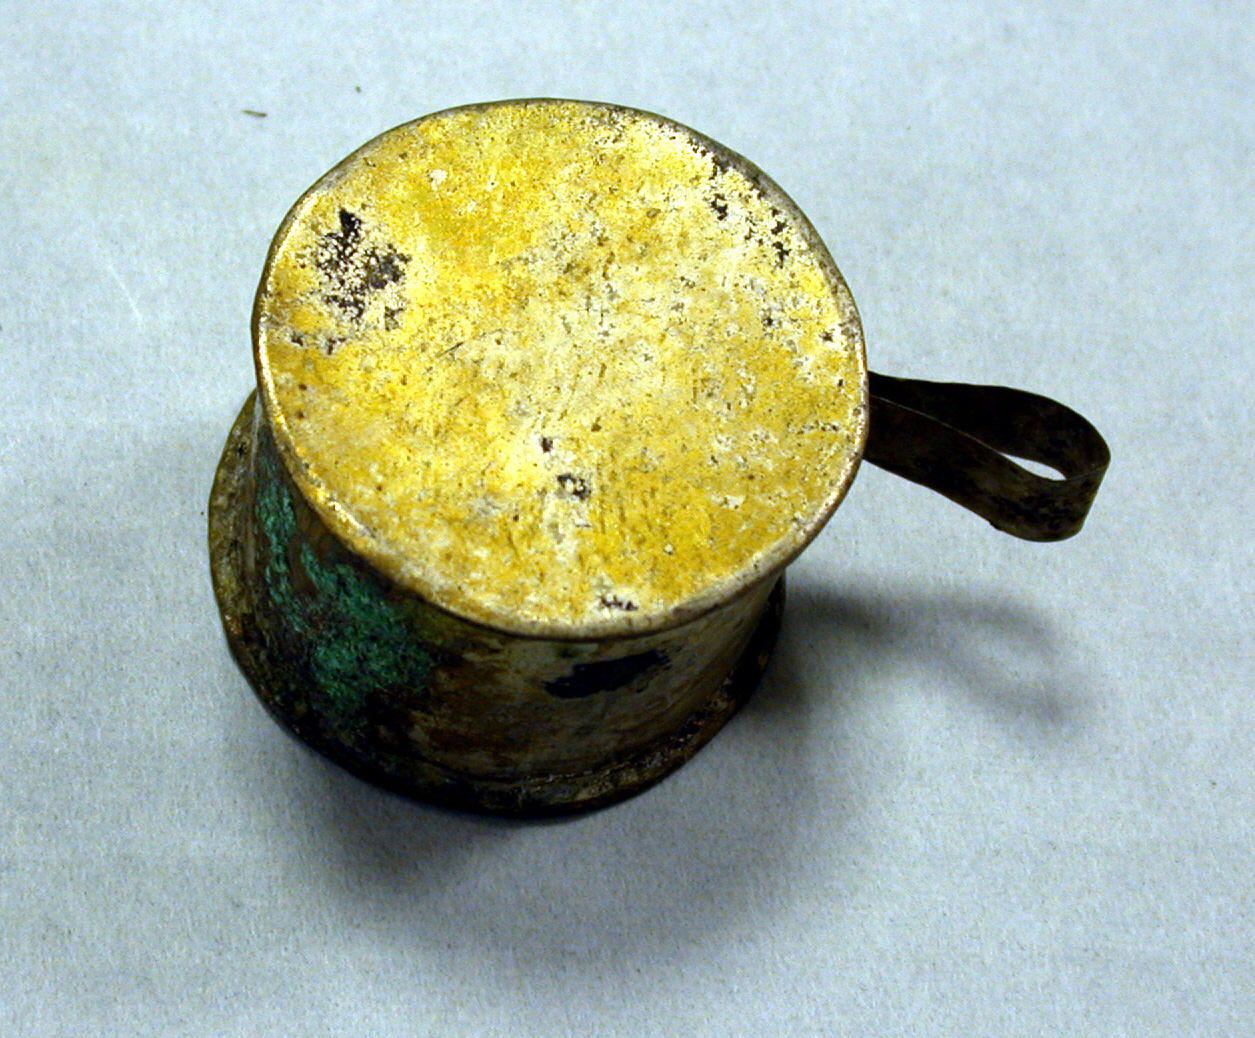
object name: drum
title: Hammered Silver Miniature Drum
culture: chancay or chimú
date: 1001-1466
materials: gilt, silver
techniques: hammering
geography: peru